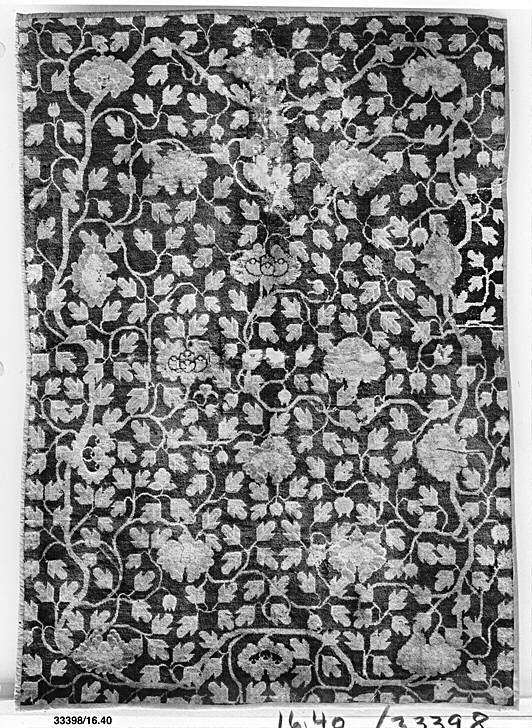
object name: rug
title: Kang Rug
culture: chinese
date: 1651-1700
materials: cotton, wool